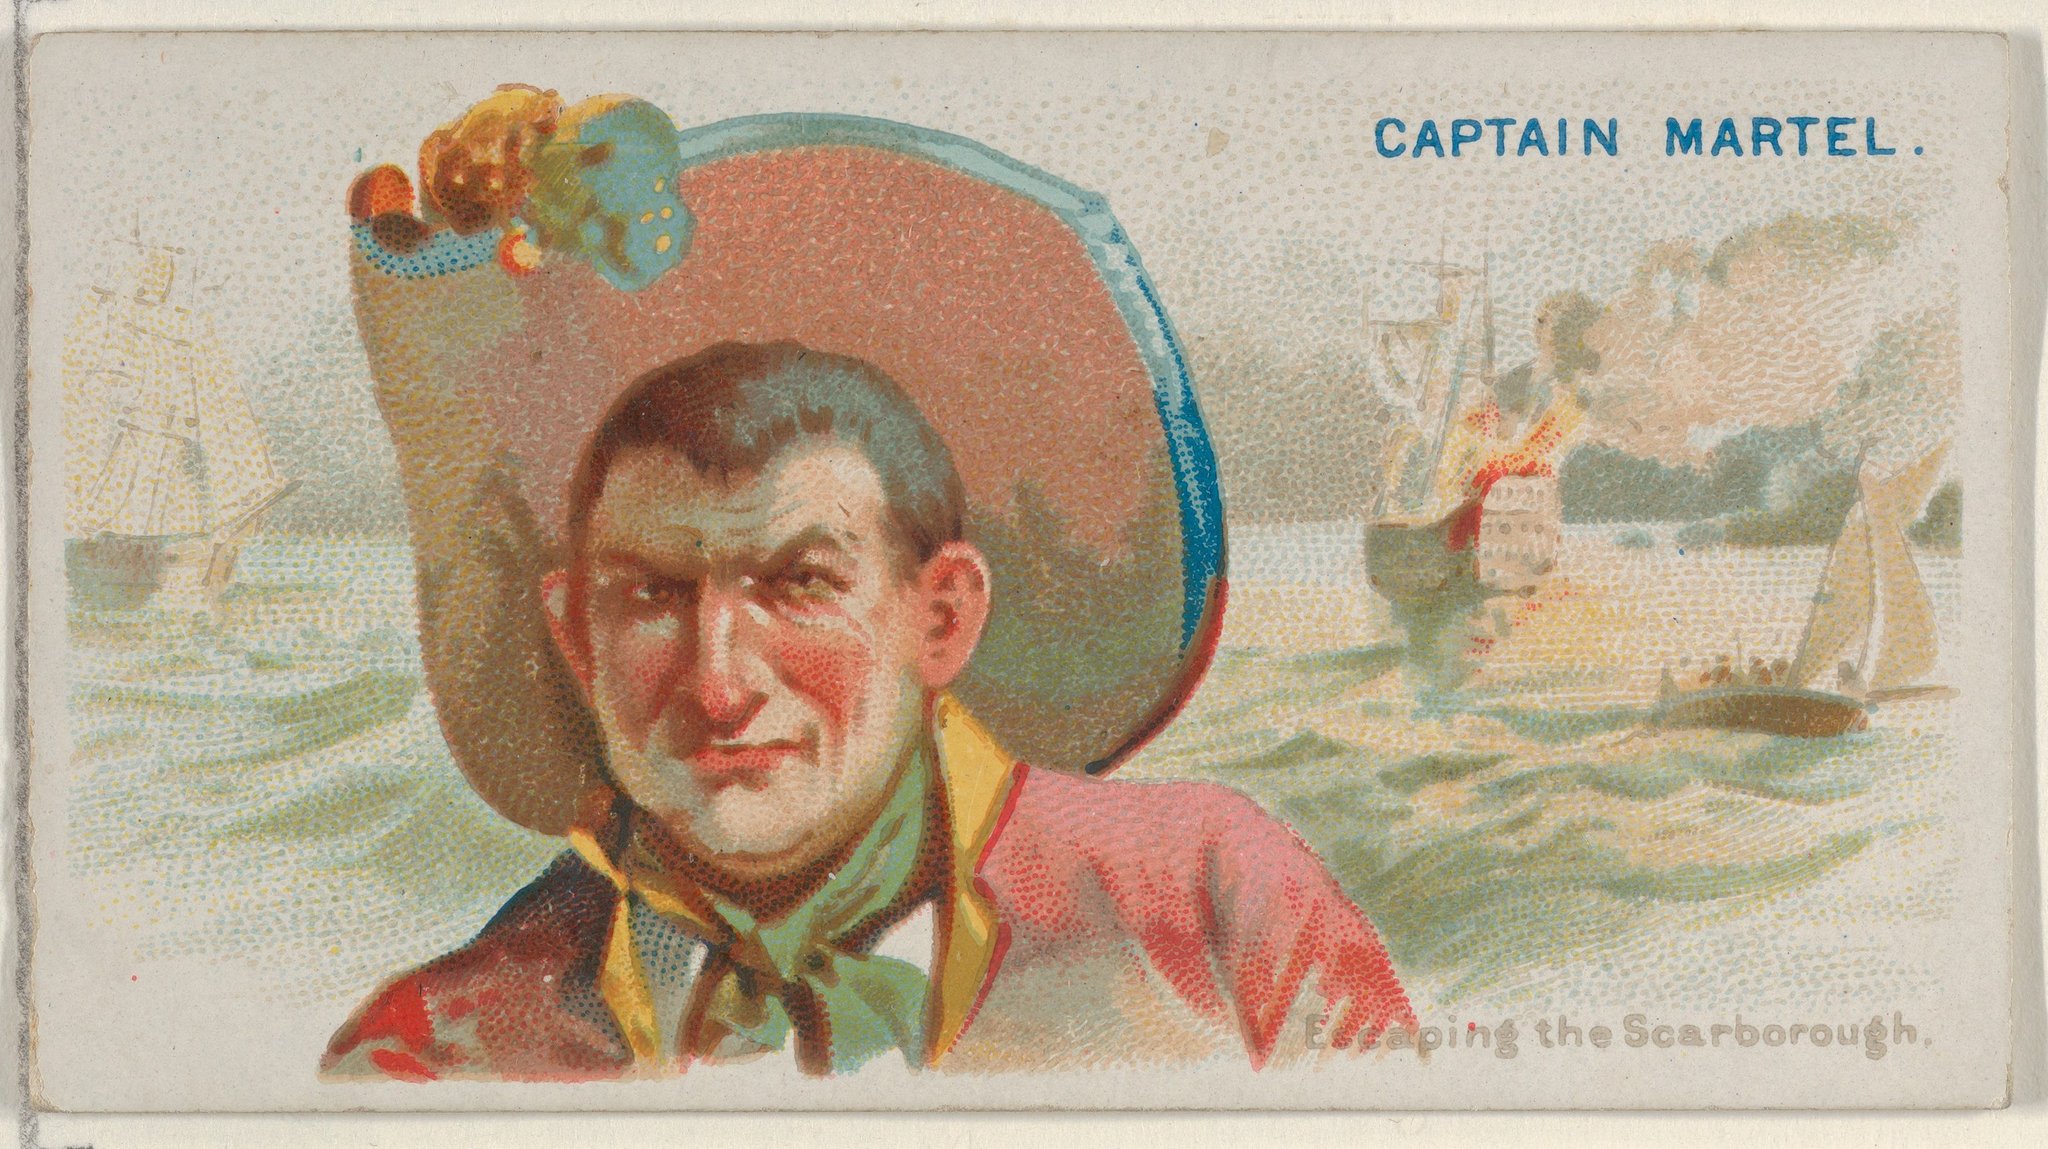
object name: print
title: Captain Martel, Escaping the Scarborough, from the Pirates of the Spanish Main series (N19) for Allen & Ginter Cigarettes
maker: allen & ginter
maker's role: publisher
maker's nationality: american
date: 1888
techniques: color lithograph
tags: men,ships